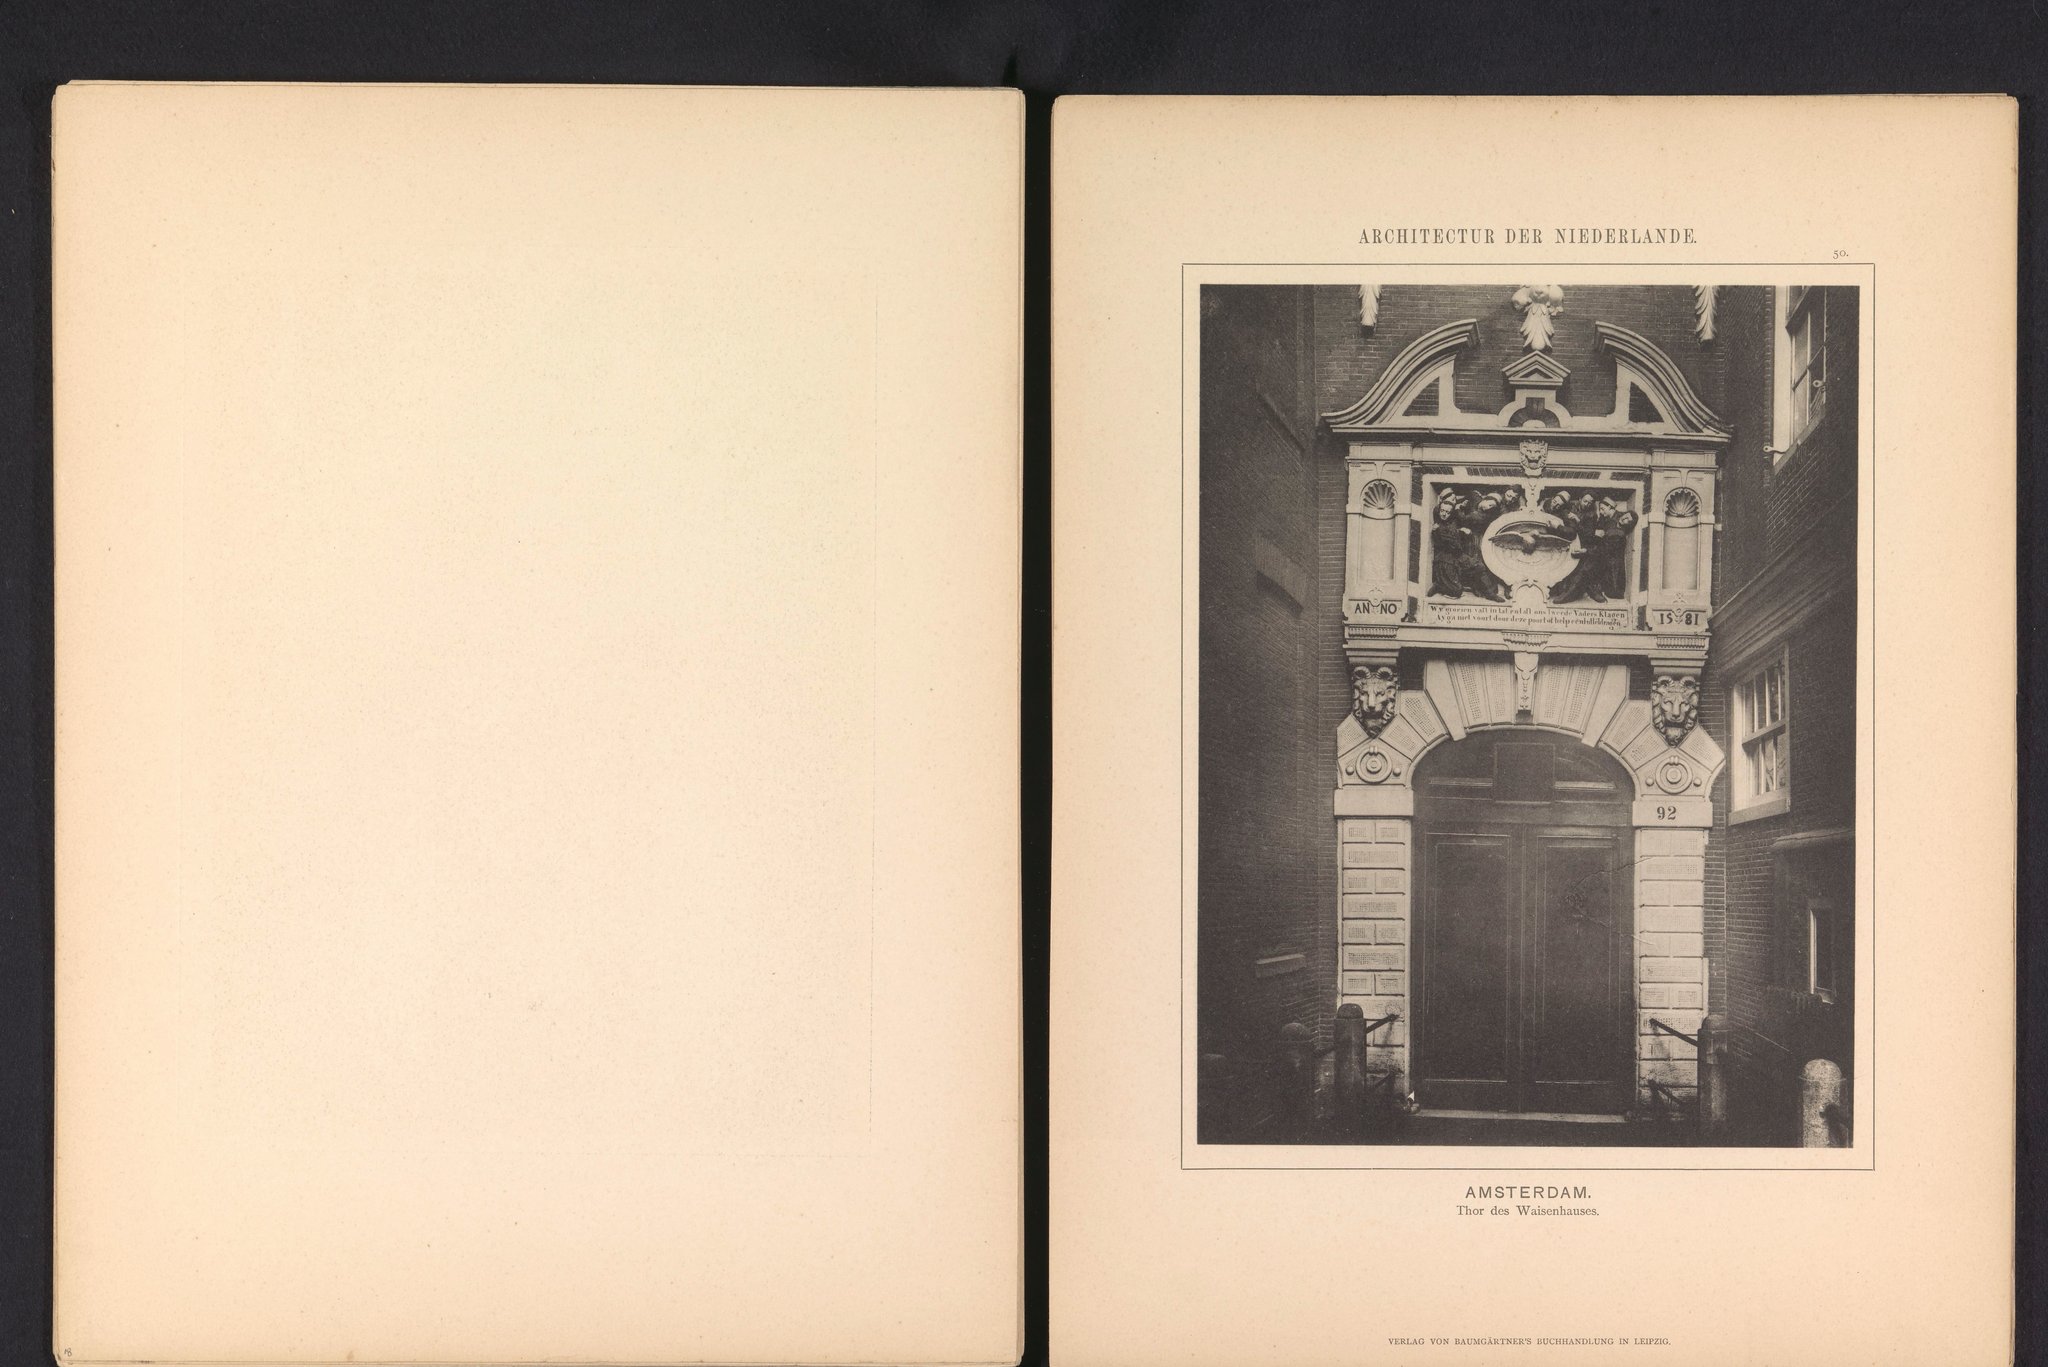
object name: photomechanical print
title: Architectur der Niederlande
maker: Anonymous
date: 1884-1894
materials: paper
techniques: photograph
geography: amsterdam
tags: stone tablet in façade, gate, entrance, orphanage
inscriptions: number: ‘50.’